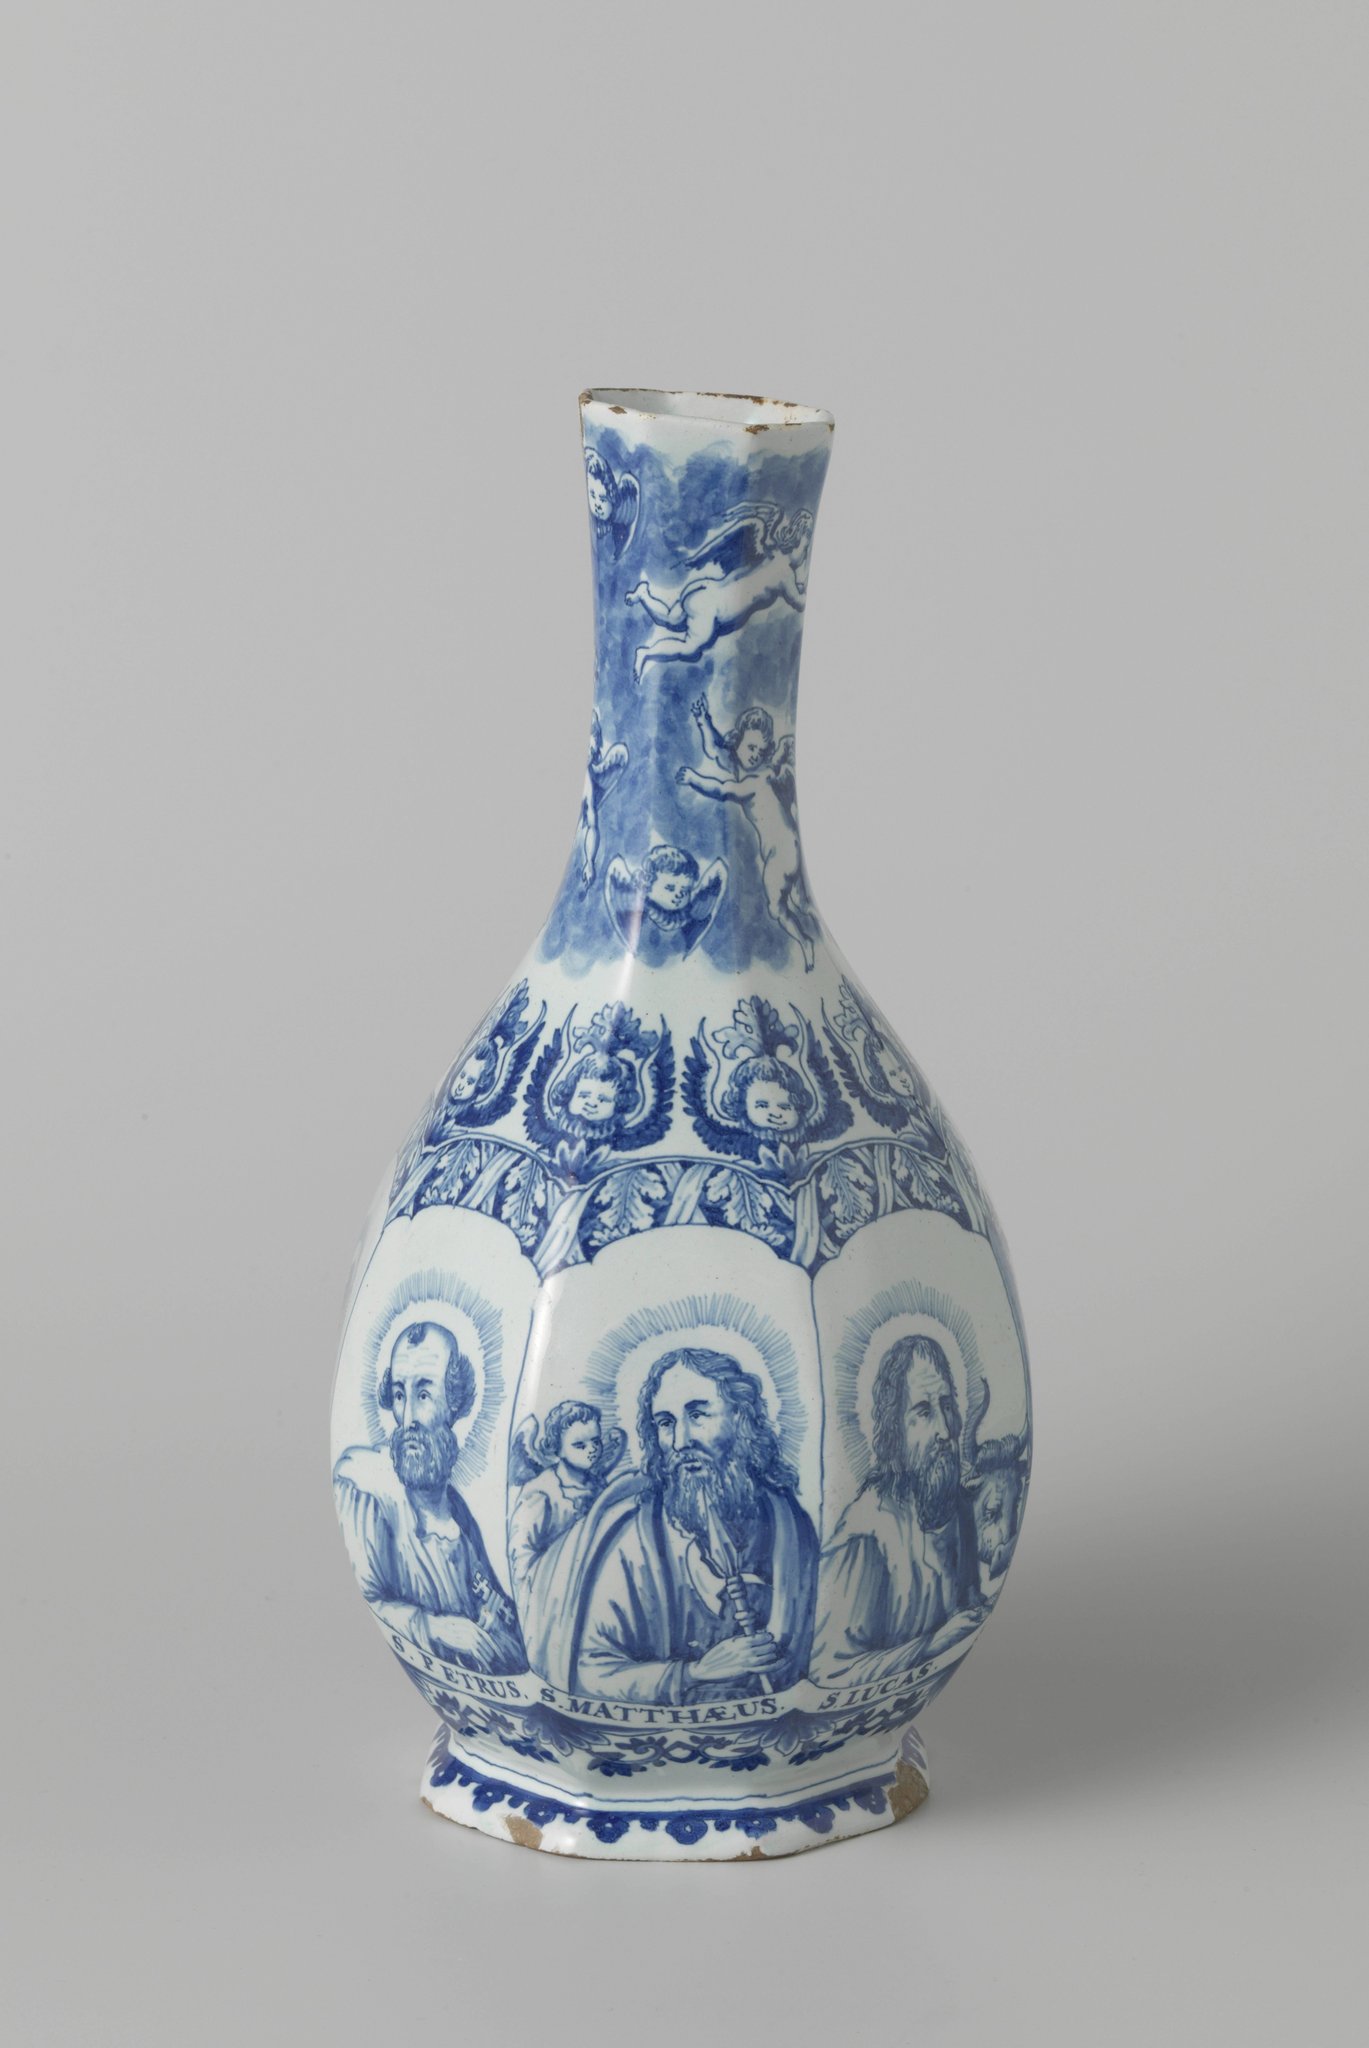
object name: vase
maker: jacobus de lange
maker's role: eigenaar plateelbakkerij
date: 1700-1710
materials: earthenware, glaze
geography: delft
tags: mary (without the christ-child), the apostle thomas; possible attributes: book, chalice, girdle, heart, lance or spear, scroll, square, stones, the apostle bartholomew; possible attributes: book, devil or dragon at feet, knife, scroll, flayed skin, staff, the apostle john the evangelist; possible attributes: book, cauldron, chalice with snake, eagle, palm, scroll, luke the evangelist; possible attributes: book, (winged) ox, portrait of the virgin, surgical instruments, painter's utensils, scroll, the apostle and evangelist matthew (mattheus); possible attributes: angel, axe, book, halberd, pen and inkhorn, purse, scroll, square, sword, christ alone (also called 'ecce homo'), the apostle peter, first bishop of rome; possible attributes: book, cock, (upturned) cross, (triple) crozier, fish, key, scroll, ship, tiara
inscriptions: inscription: ‘S. MARIA’, inscription: ‘S. THOMAS’, inscription: ‘S. MATTHAEUS’, inscription: ‘S. IOANNIS.BA’, inscription: ‘S. LUCAS’, inscription: ‘ECCE HOMO’, inscription: ‘S. PETRUS’, inscription: ‘S. BARTOLOMAEUS’, mark: ‘figuratief teken ster/ 125./ figuratief teken kruis in cirkel’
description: Vaas van aardewerk, achthoekig en flesvormig met dito slanke hals. Beschilderd in blauw op de witte tinglazuur: op de acht vakken Christus, Petrus, Mattheus, Lucas, Johannes de Doper, Bartholomeus, Thomas en Maria, allen in halffiguur met hun attributen; er onder hun namen: ECCE HOMO, S.PETRUS, S.MATTHAEUS, S.LUCAS, S.IOANNIS.BA., S.BARTOLOMAEUS, S.THOMAS, S.MARIA. Onder deze opschriften halve rozetten met symmetrische bladranken. Boven de figuren een met linten omwonden bladkrans, waarop engelenkopjes met vleugels en een lelienmotief op het hoofd, staan. Op de hals vliegende putti en engelenkopjes tussen wolken. Langs de voetrand een bladrandje. Gemerkt in blauw met een sterretje waaronder het getal 125 waaronder weer een in vieren gedeeld rondje.